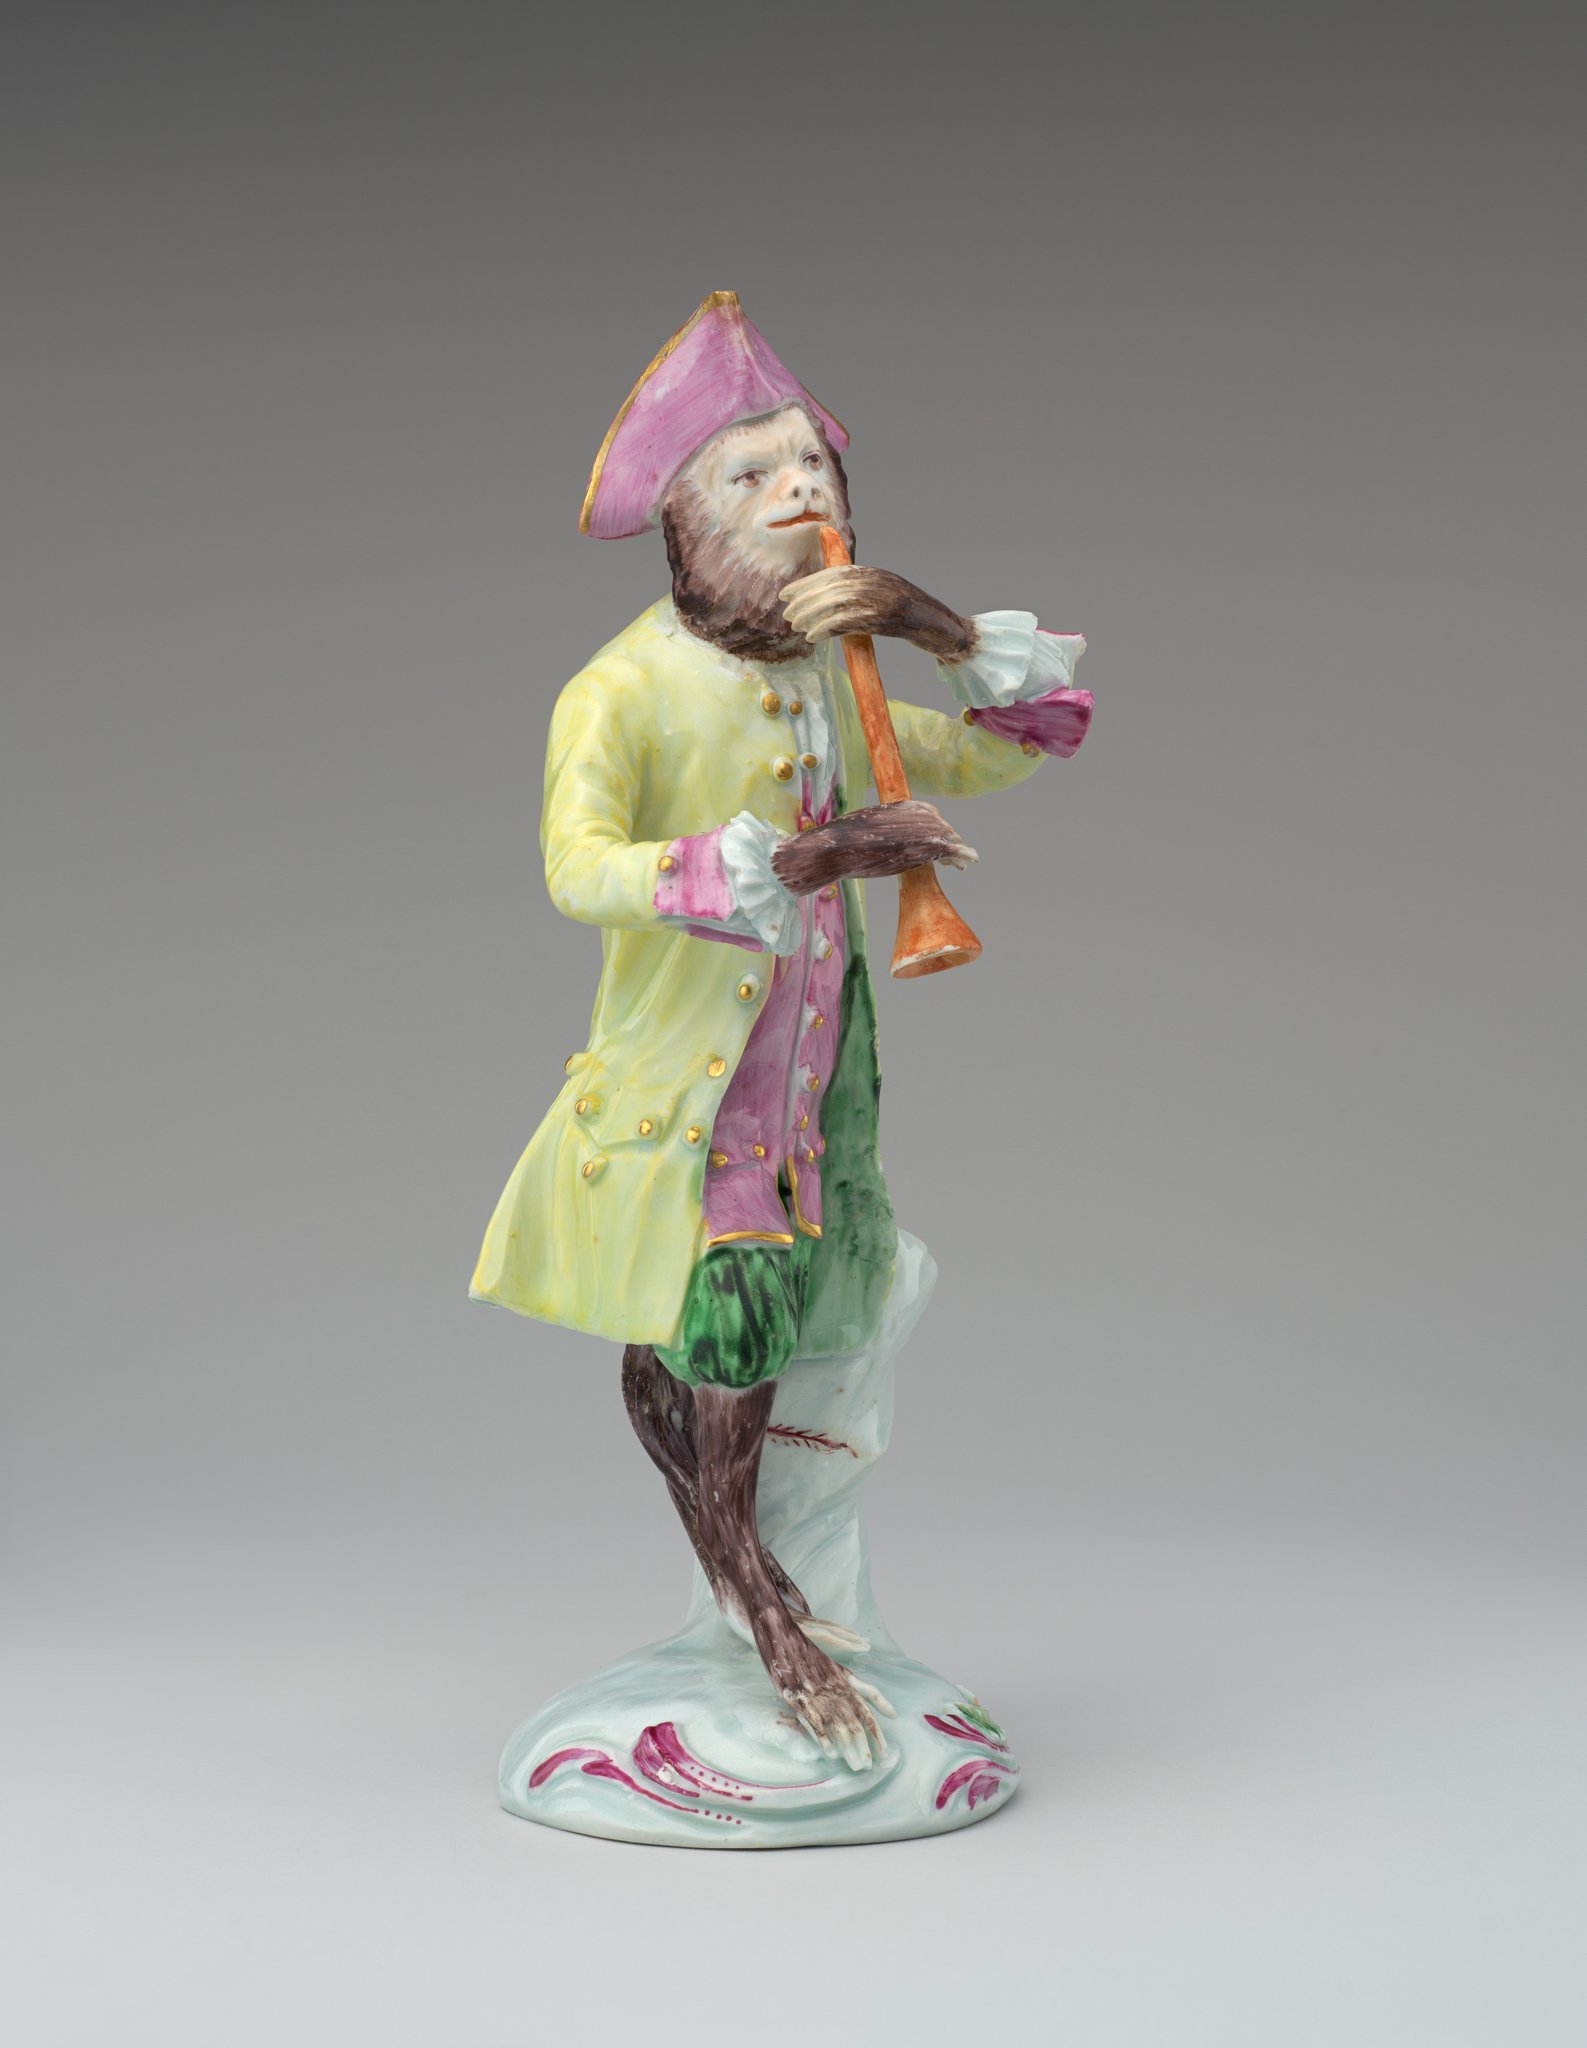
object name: figure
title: Monkey musician (part of a set)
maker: derby porcelain manufactory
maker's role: factory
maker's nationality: british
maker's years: 1751-1785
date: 1760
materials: soft paste porcelain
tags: monkeys,musicians